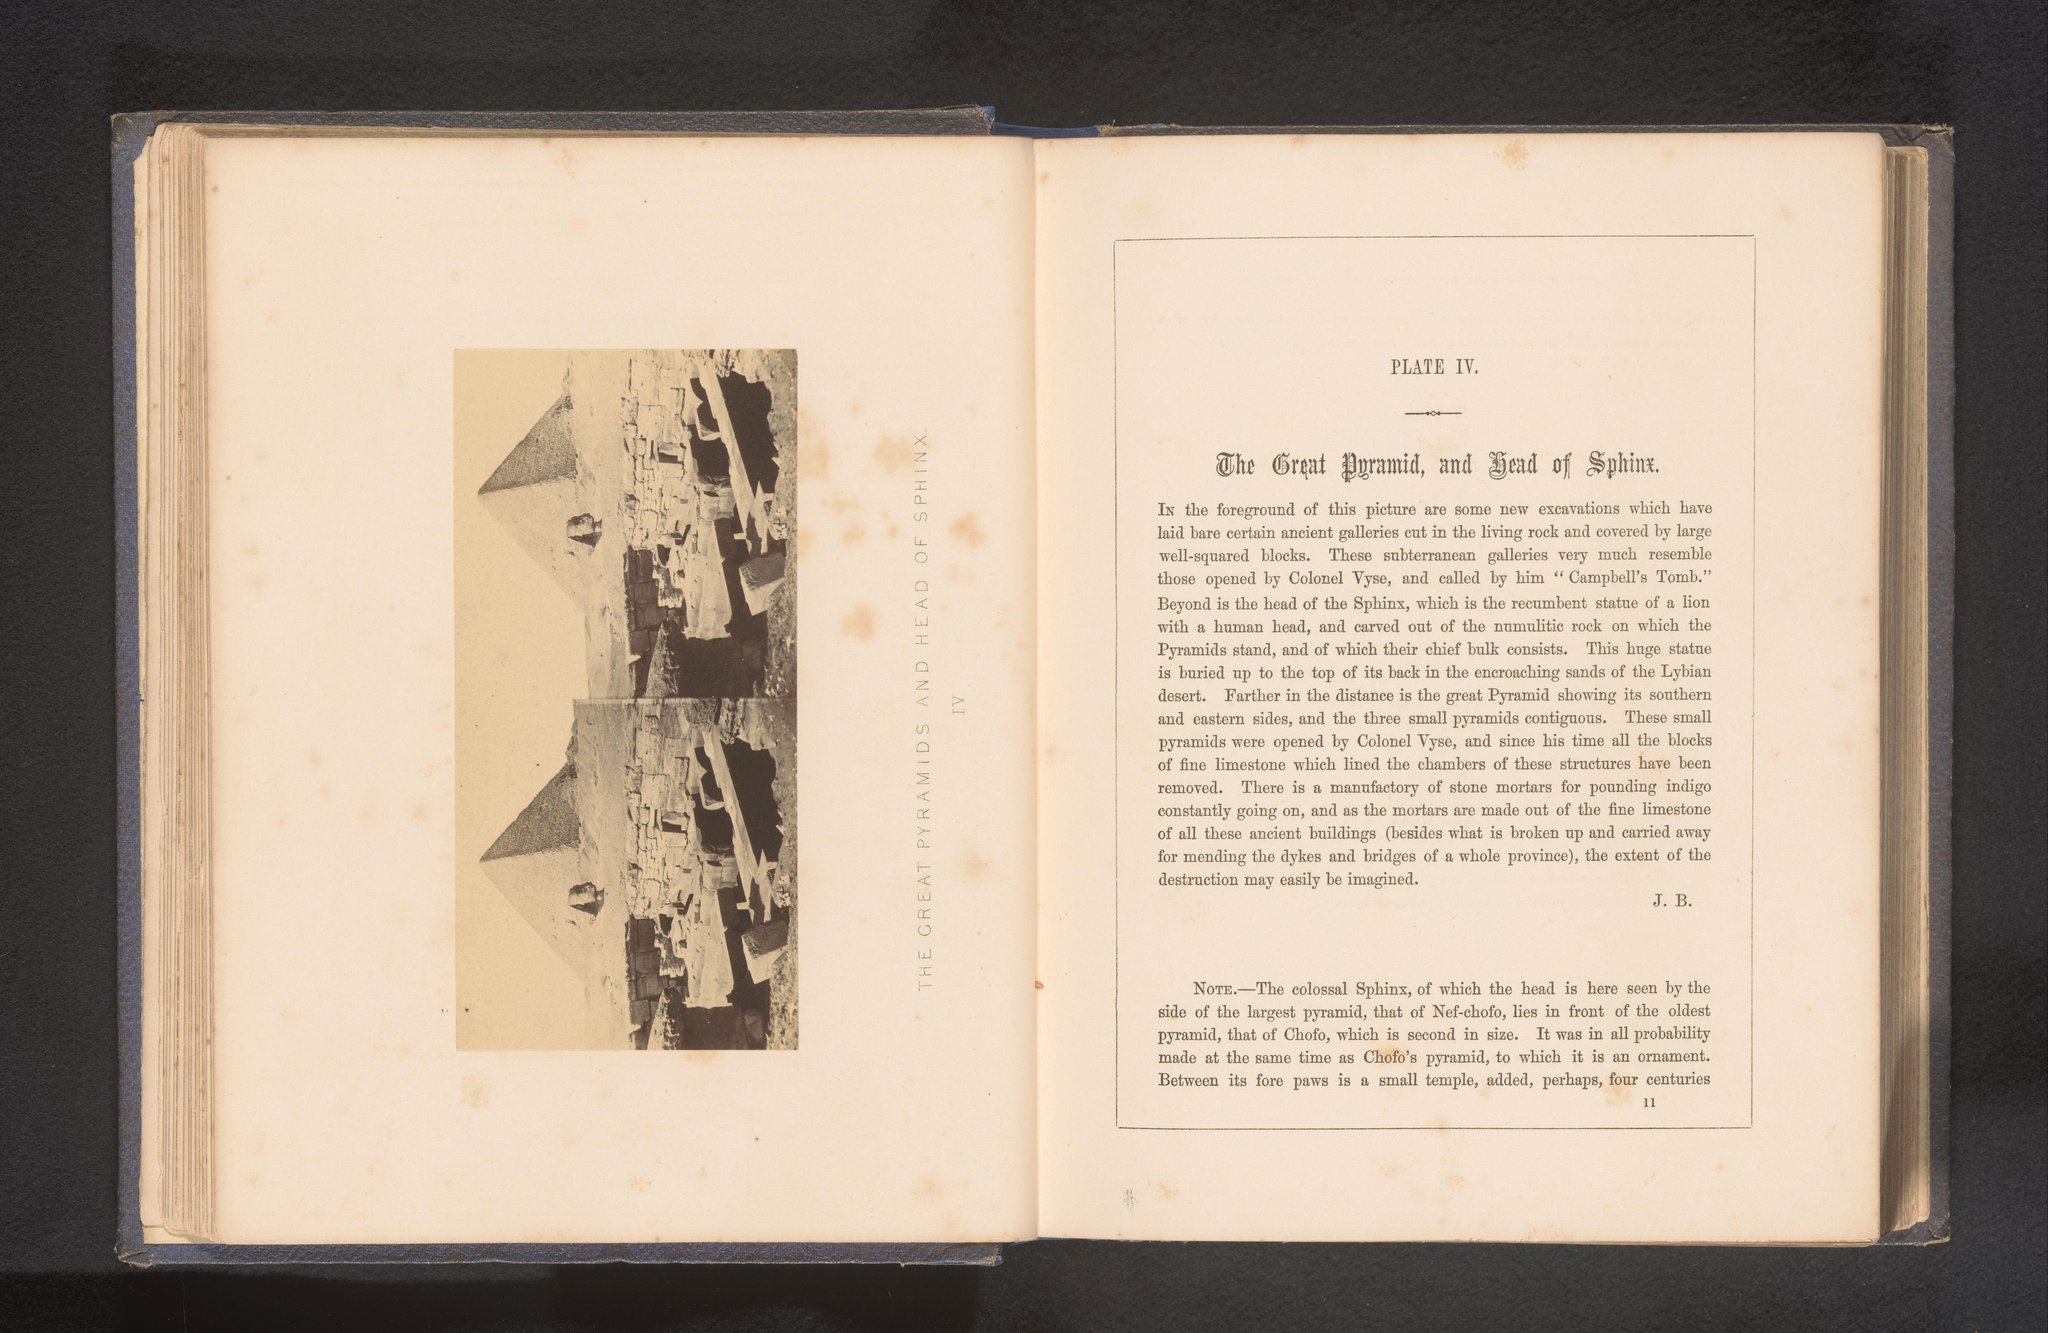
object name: page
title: Sfinx van Gizeh met op de achtergrond de piramide van Cheops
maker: francis frith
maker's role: publisher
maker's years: 1822-1898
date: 1857-1862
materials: photographic support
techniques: albumen print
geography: gizeh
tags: sphinx (lion/woman); 'sfinge' (ripa) - aa - female human figure, egyptian pyramids (wonder of the world)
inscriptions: number: ‘IV’